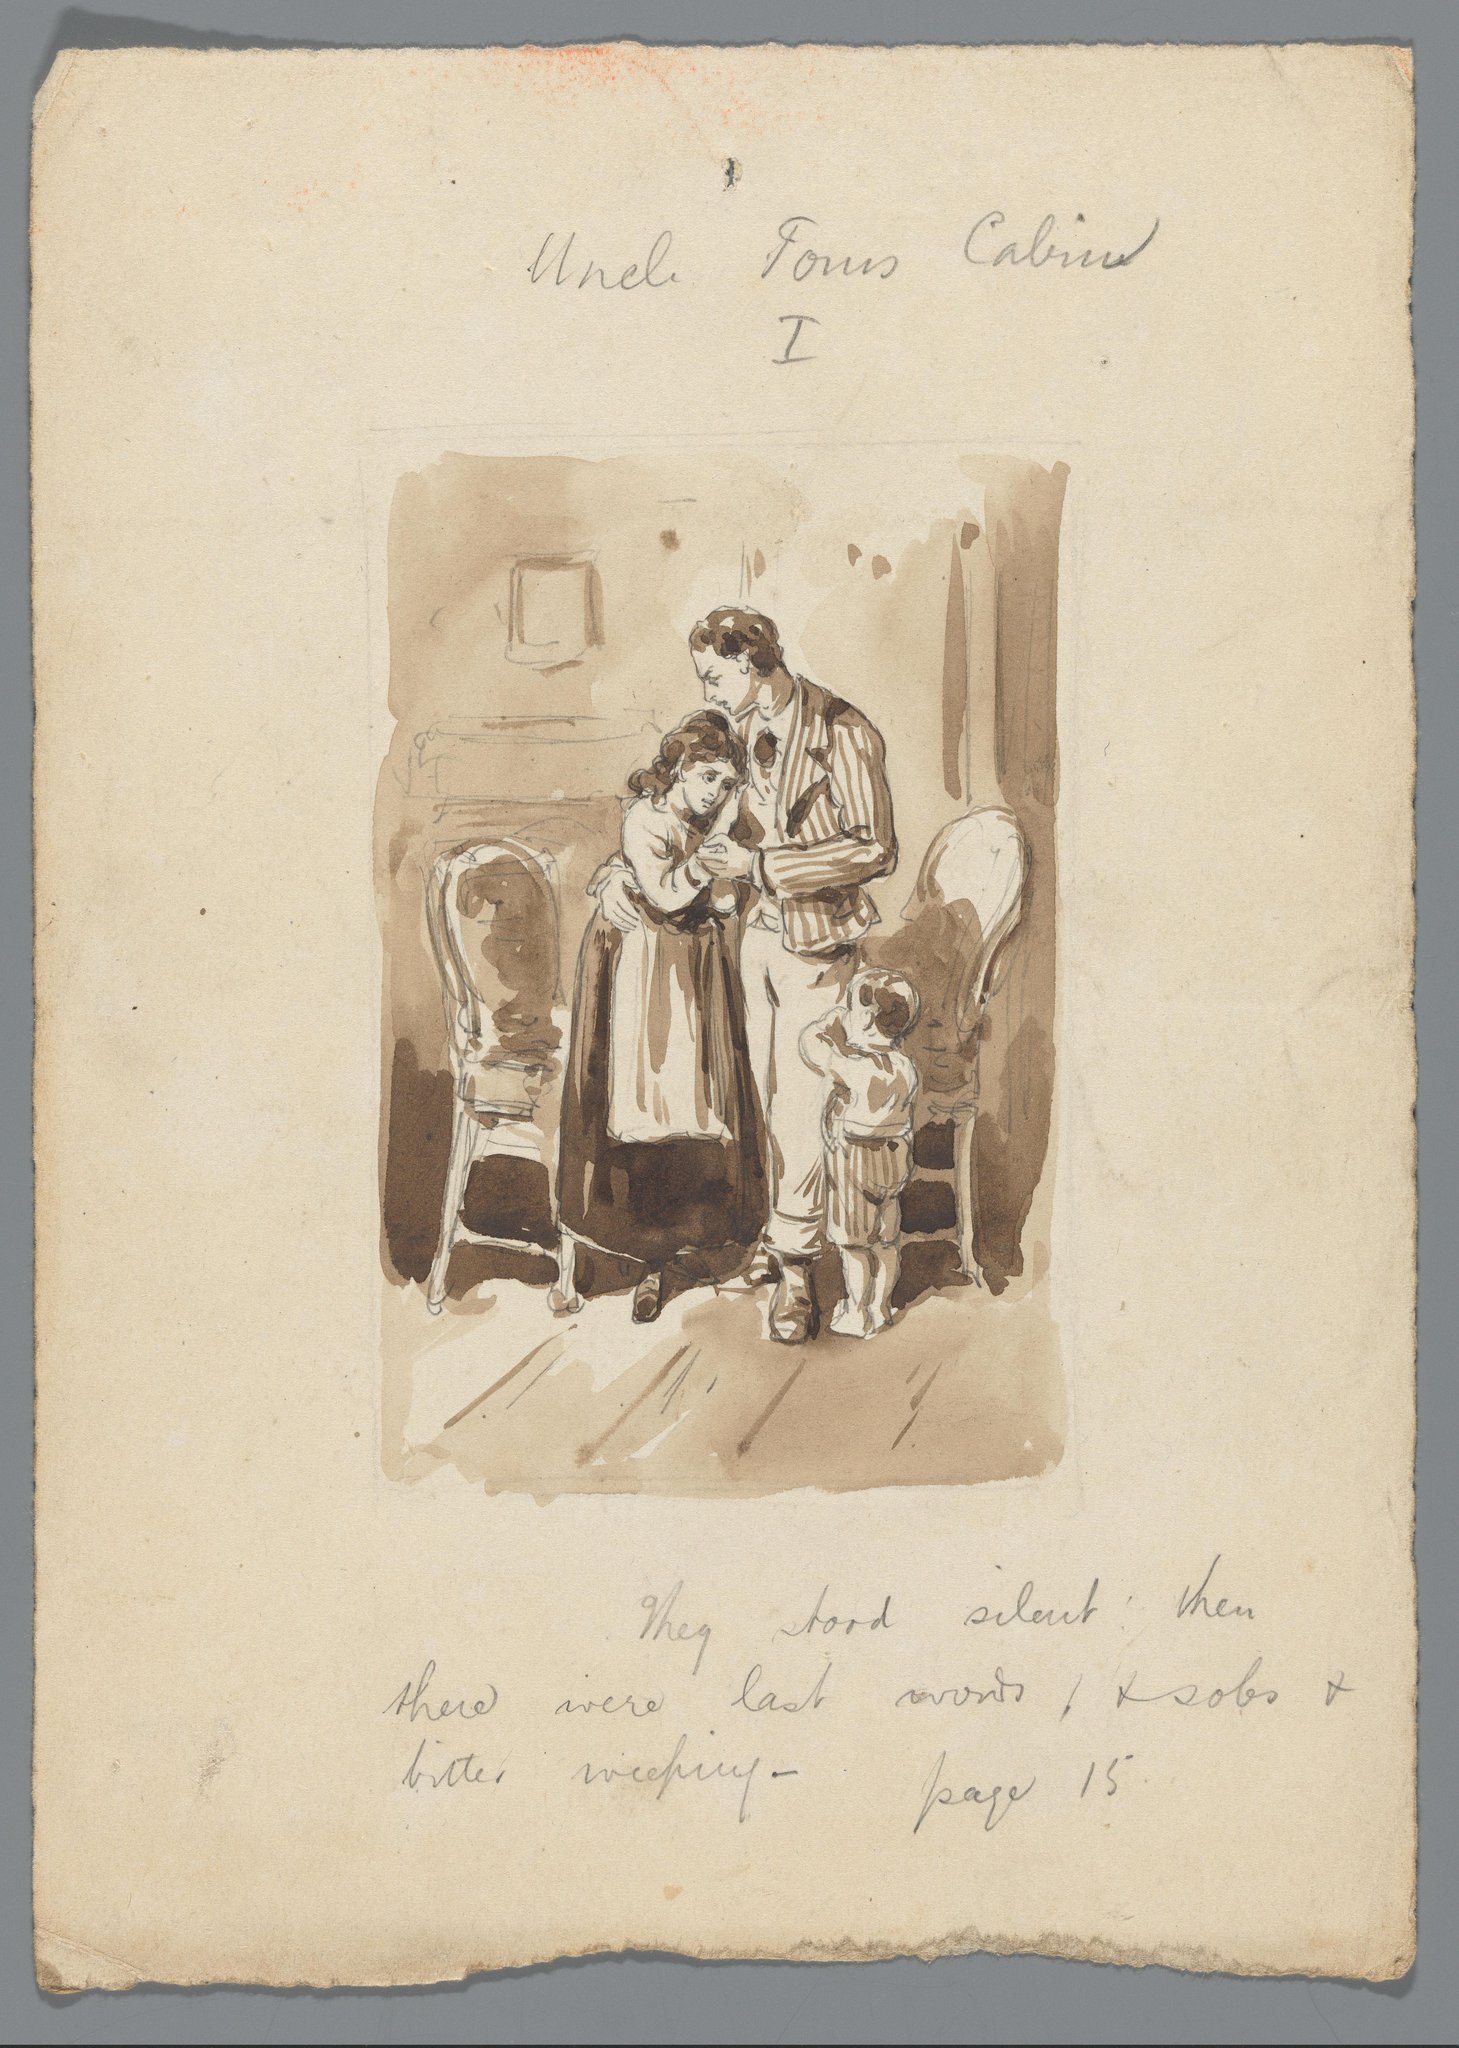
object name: design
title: Afscheidstafereel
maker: joseph ludovic scheidel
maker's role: draughtsman, painter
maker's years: 1848-1895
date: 1852-1895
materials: paper, pencil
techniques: brush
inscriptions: annotation: ‘engels citaat verwijzend naar de geïllustreerde passage’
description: Ontwerp voor een boekillustratie in Harriët Beecher Stowe, "De Negerhut van Oom Tom".